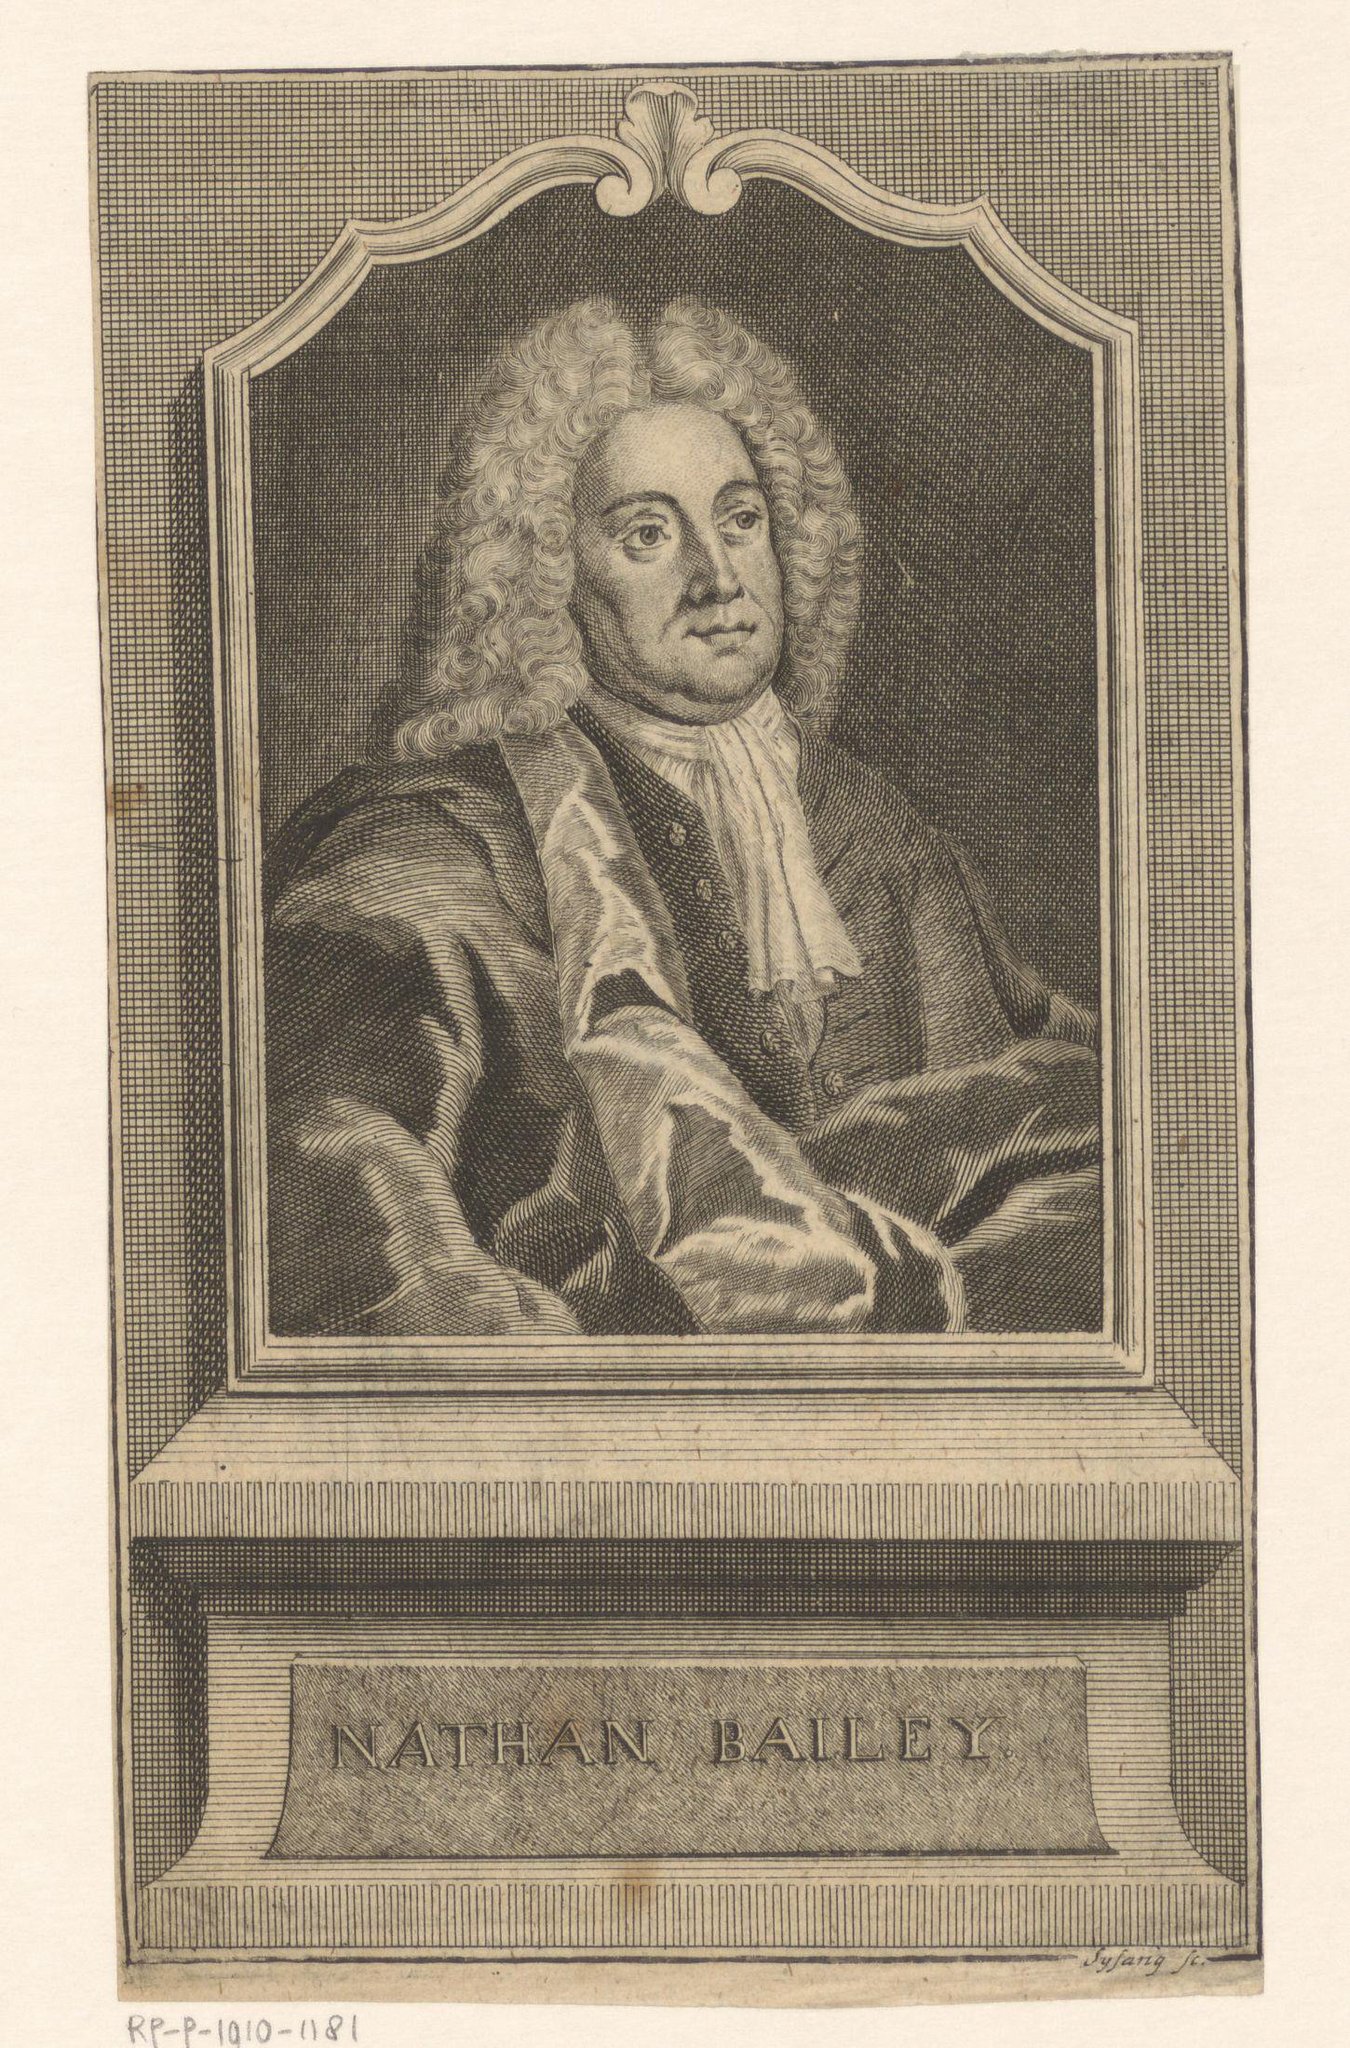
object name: print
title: Portret van Nathaniel Bailey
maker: johann christoph sysang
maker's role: print maker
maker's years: 1703-1757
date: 1713-1757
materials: paper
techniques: engraving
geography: germany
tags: historical persons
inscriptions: collector's mark: Lugt 2228